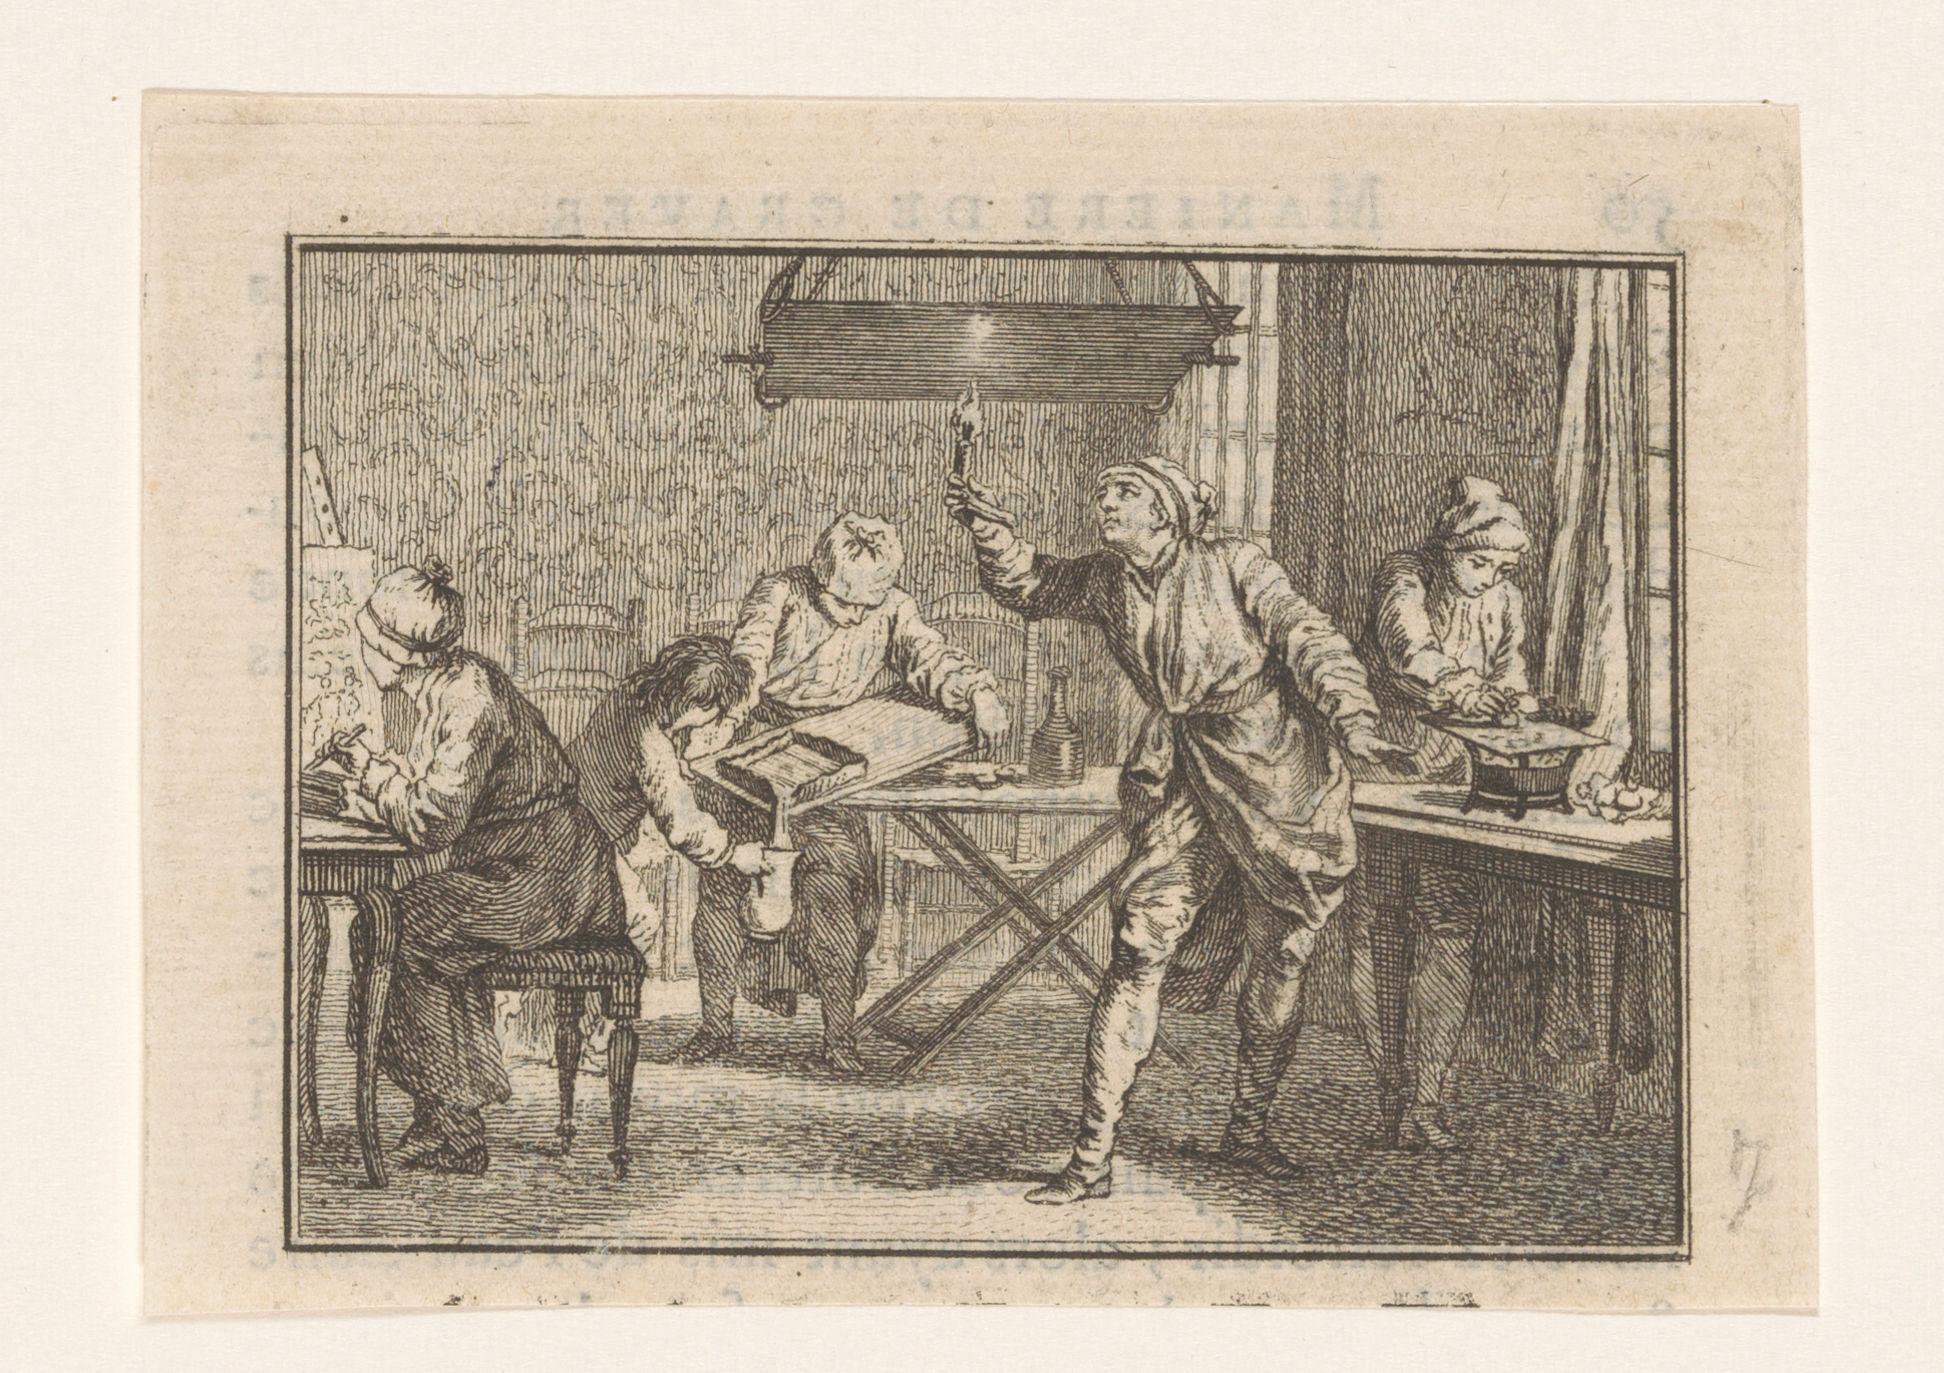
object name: print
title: Atelier van een prentmaker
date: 1745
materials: paper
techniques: etching, letterpress printing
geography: paris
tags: engraver, etcher, artist at work, in his workshop (+ graphic arts), tools, implements of graphic artist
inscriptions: collector's mark: Lugt 4780, collector's mark: Lugt 2228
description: Atelier van een prentmaker met in het midden een man die met een kaars een koperplaat beroet. Achter hem twee personen die etswater uit een bak laten lopen. Rechts is iemand bezig met het verwarmen van inkt. Links een prentmaker, waarschijnlijk bezig met stippelwerk.